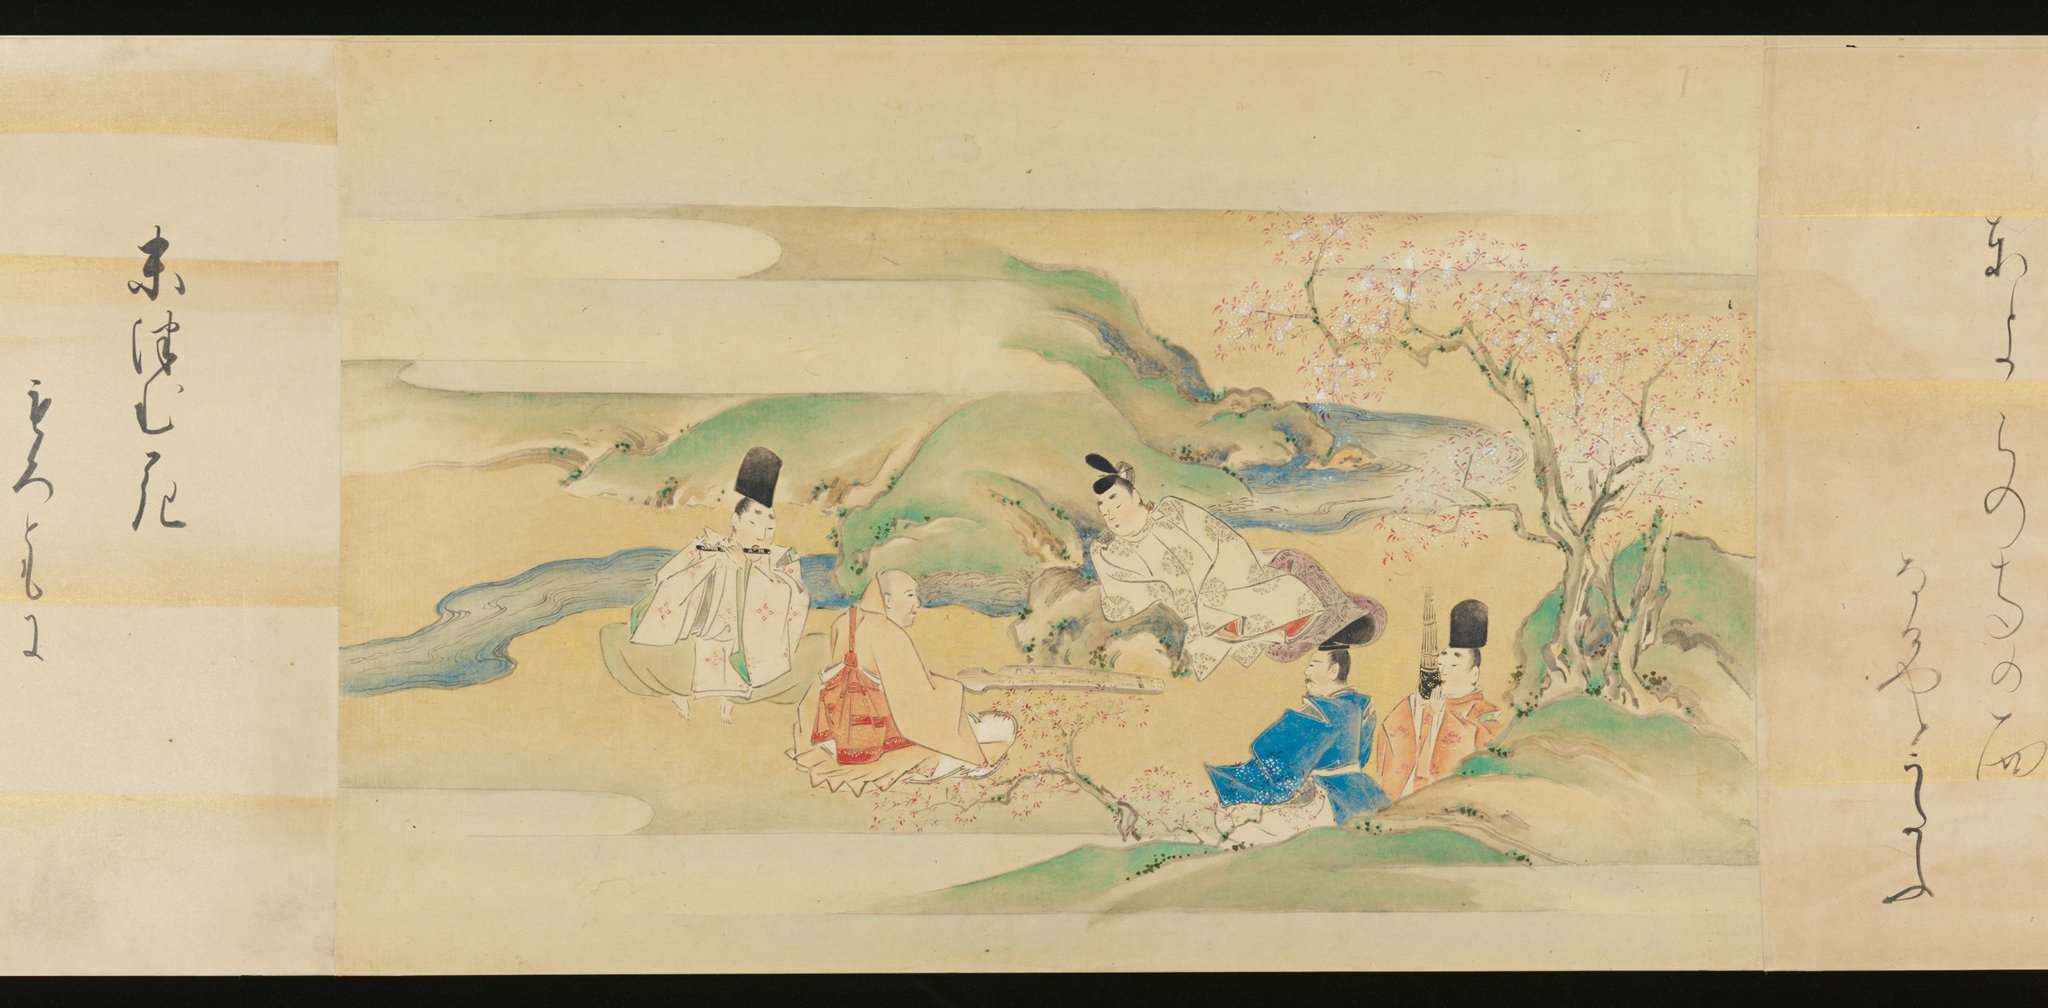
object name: handscroll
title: The Tale of Genji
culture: japanese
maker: kaihō yūsetsu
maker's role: artist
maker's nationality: japanese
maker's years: 1598-1677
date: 1601-1700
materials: ink, paper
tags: interiors,men,women,flutes,games